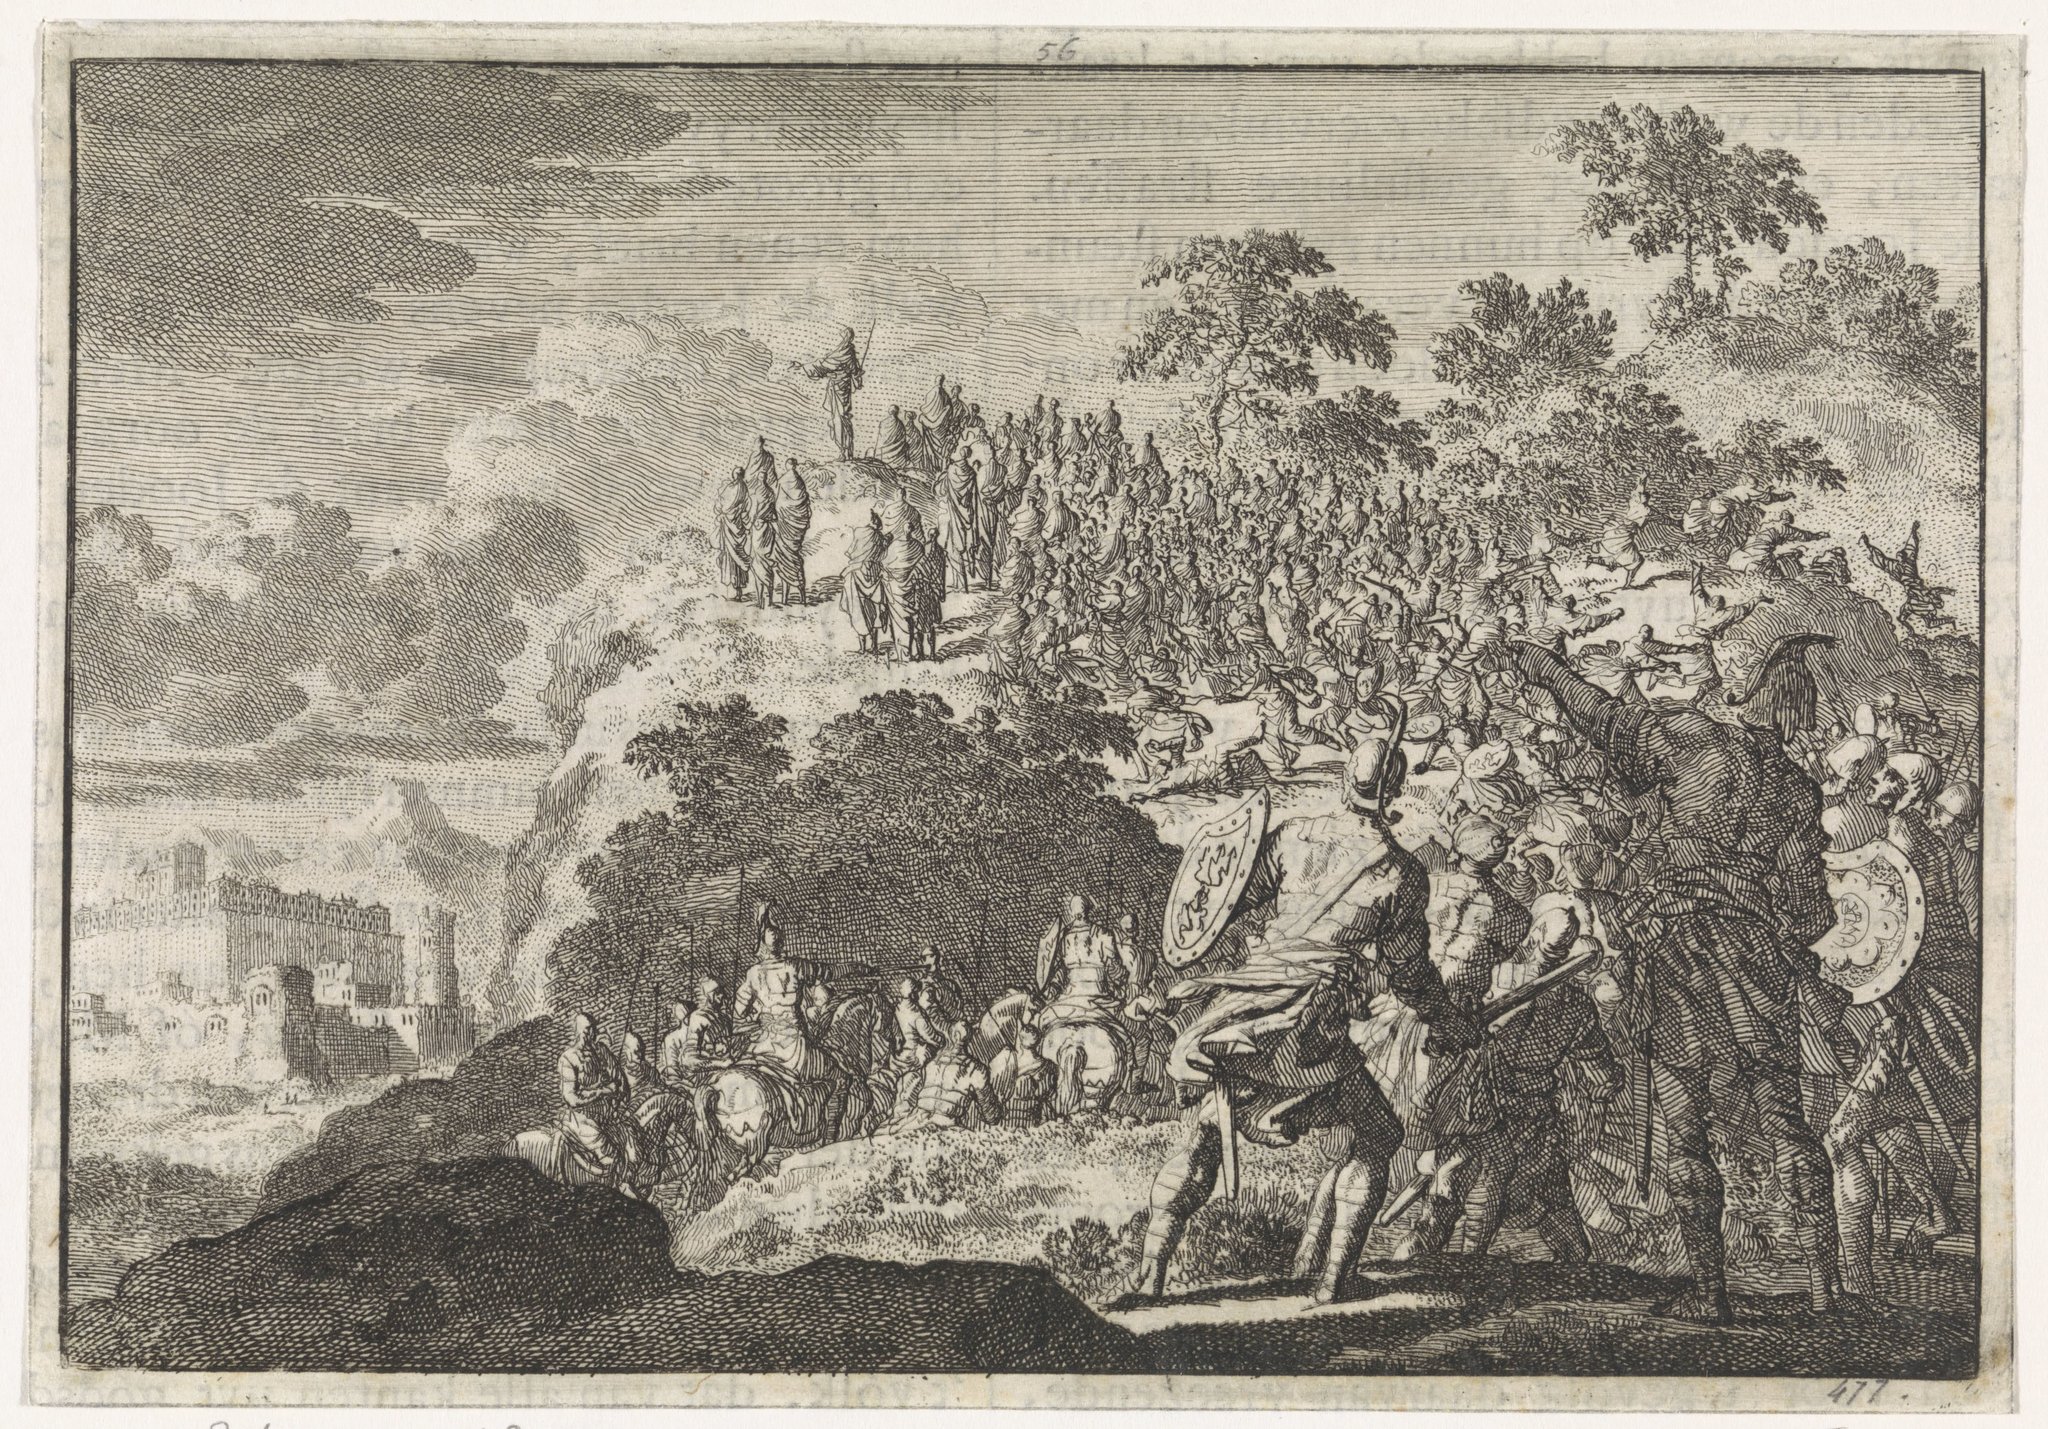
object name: print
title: Krijgslieden van stadhouder Felix vallen een volksmenigte op de Olijfberg aan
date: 1704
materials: paper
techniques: etching, letterpress printing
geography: amsterdam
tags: (high) hill, (military) attack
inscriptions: collector's mark: Lugt 2228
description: Prent opgenomen in: Josephus, Flavius. Alle de Werken, 2 delen. Amsterdam: Pieter Mortier, 1704, dl. 1, p. 477.